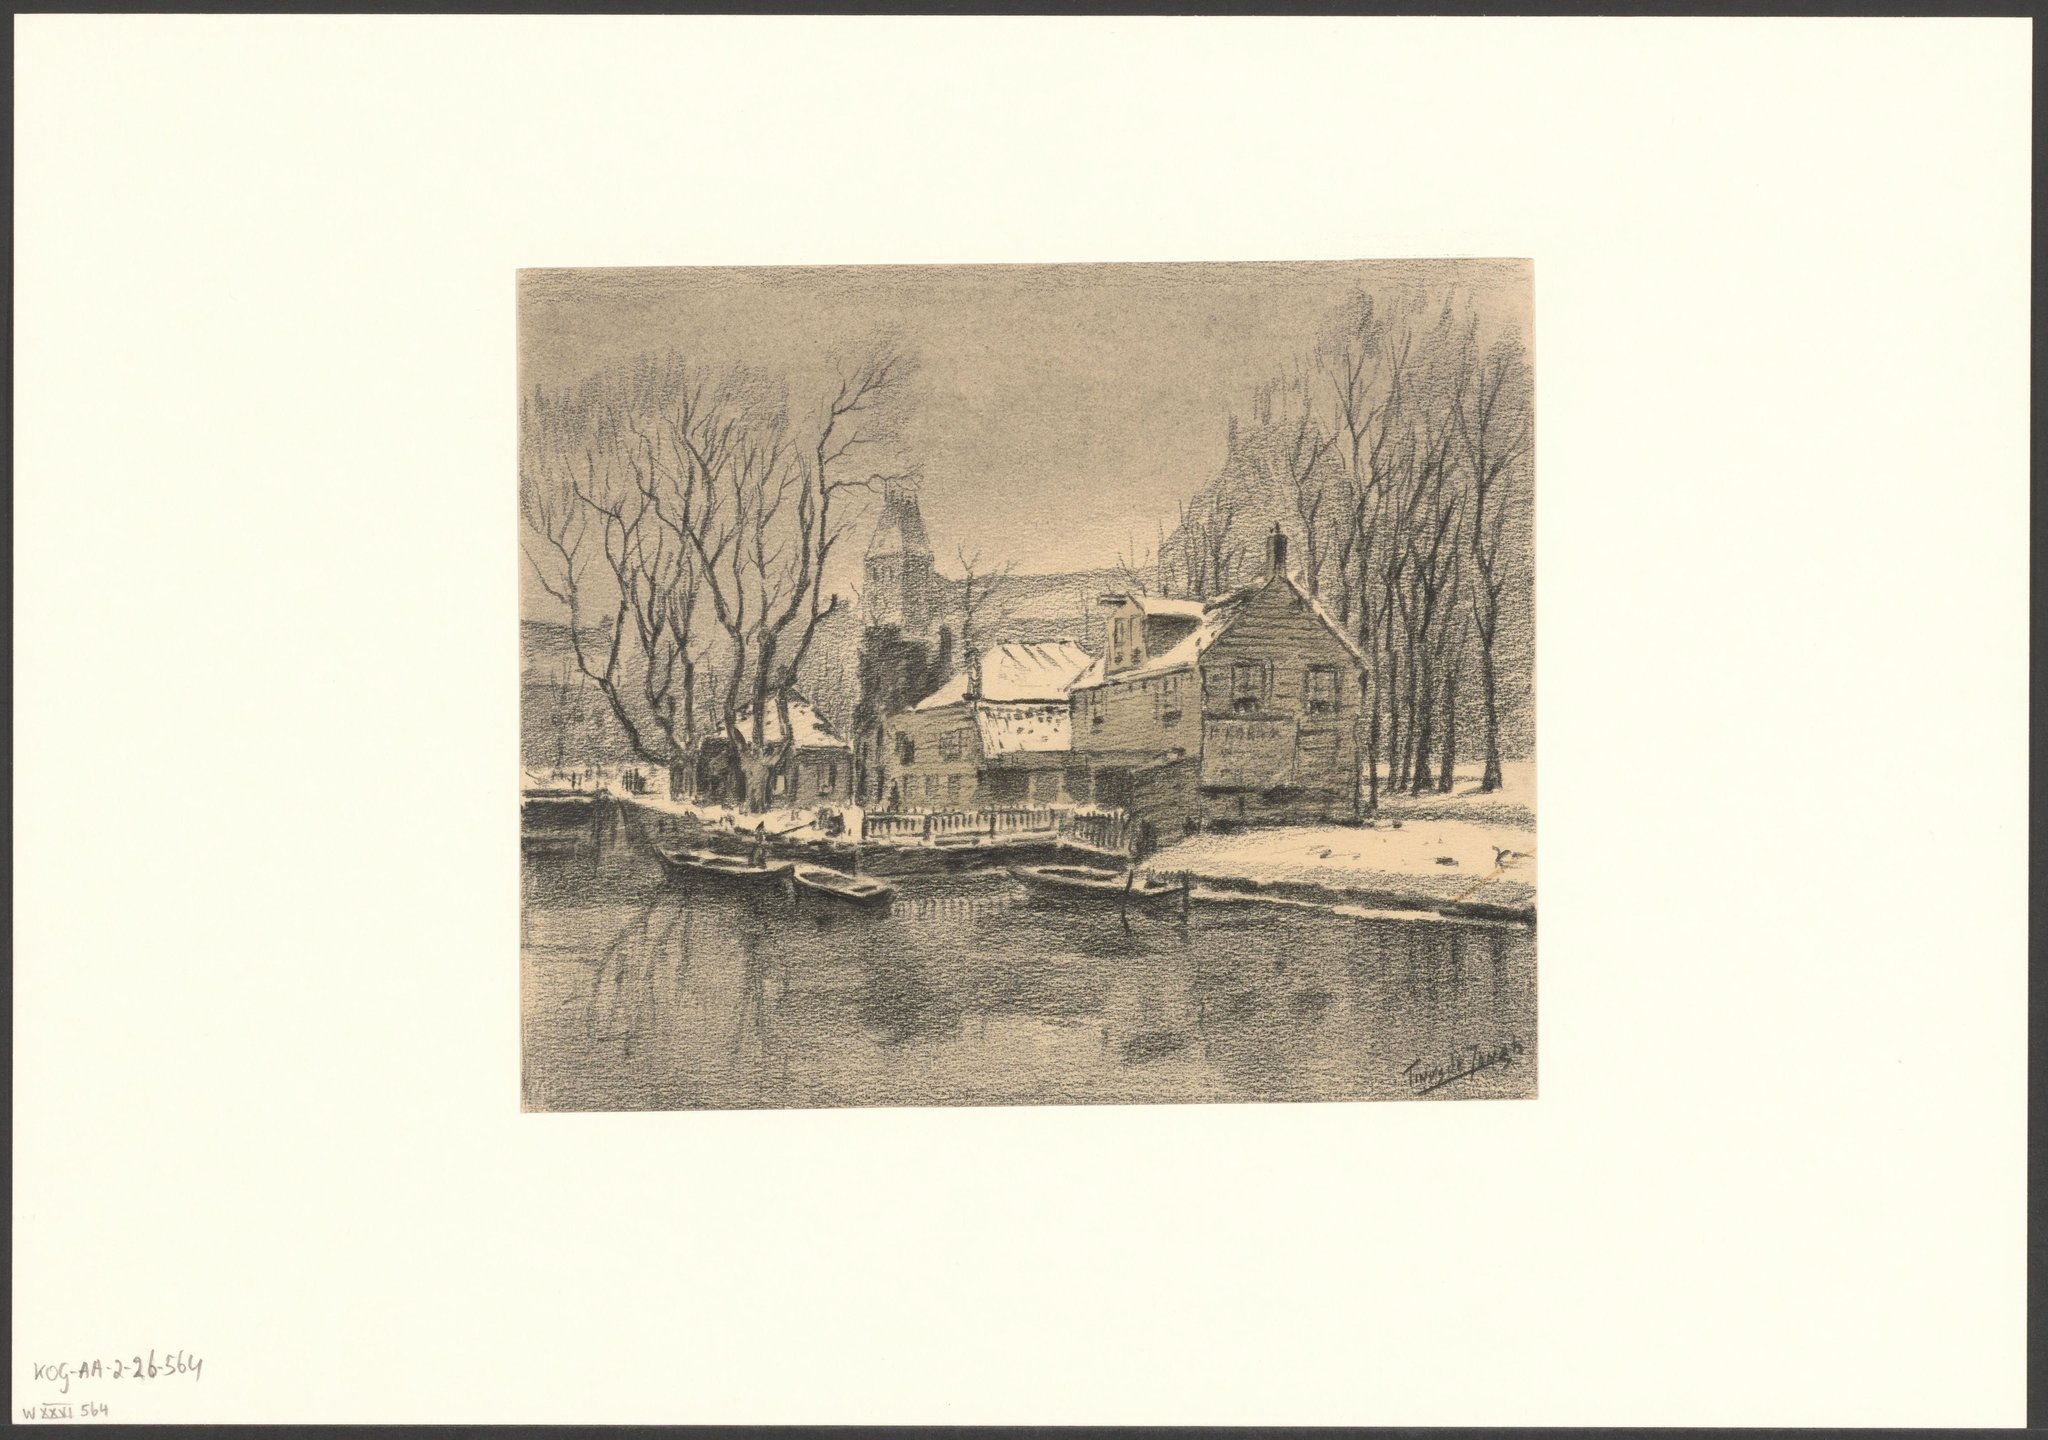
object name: drawing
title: Gezicht op de Boerenwetering en het Rijksmuseum Amsterdam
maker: tinus de jongh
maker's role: print maker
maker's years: 1885-1942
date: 1895-1942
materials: chalk, ink, paper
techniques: brush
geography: amsterdam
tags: city-view in general; 'veduta', canal, permanent exhibition, museum, farm or solitary house in landscape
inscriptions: inscription: ‘overhaal bij 't Rijksmuseum’, name: ‘Tinus de Jongh’, collector's mark: Lugt 800a, signature: ‘Tinus de Jongh’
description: Tekening binnen de Atlas Van Eck ingedeeld op wijknummer 26.